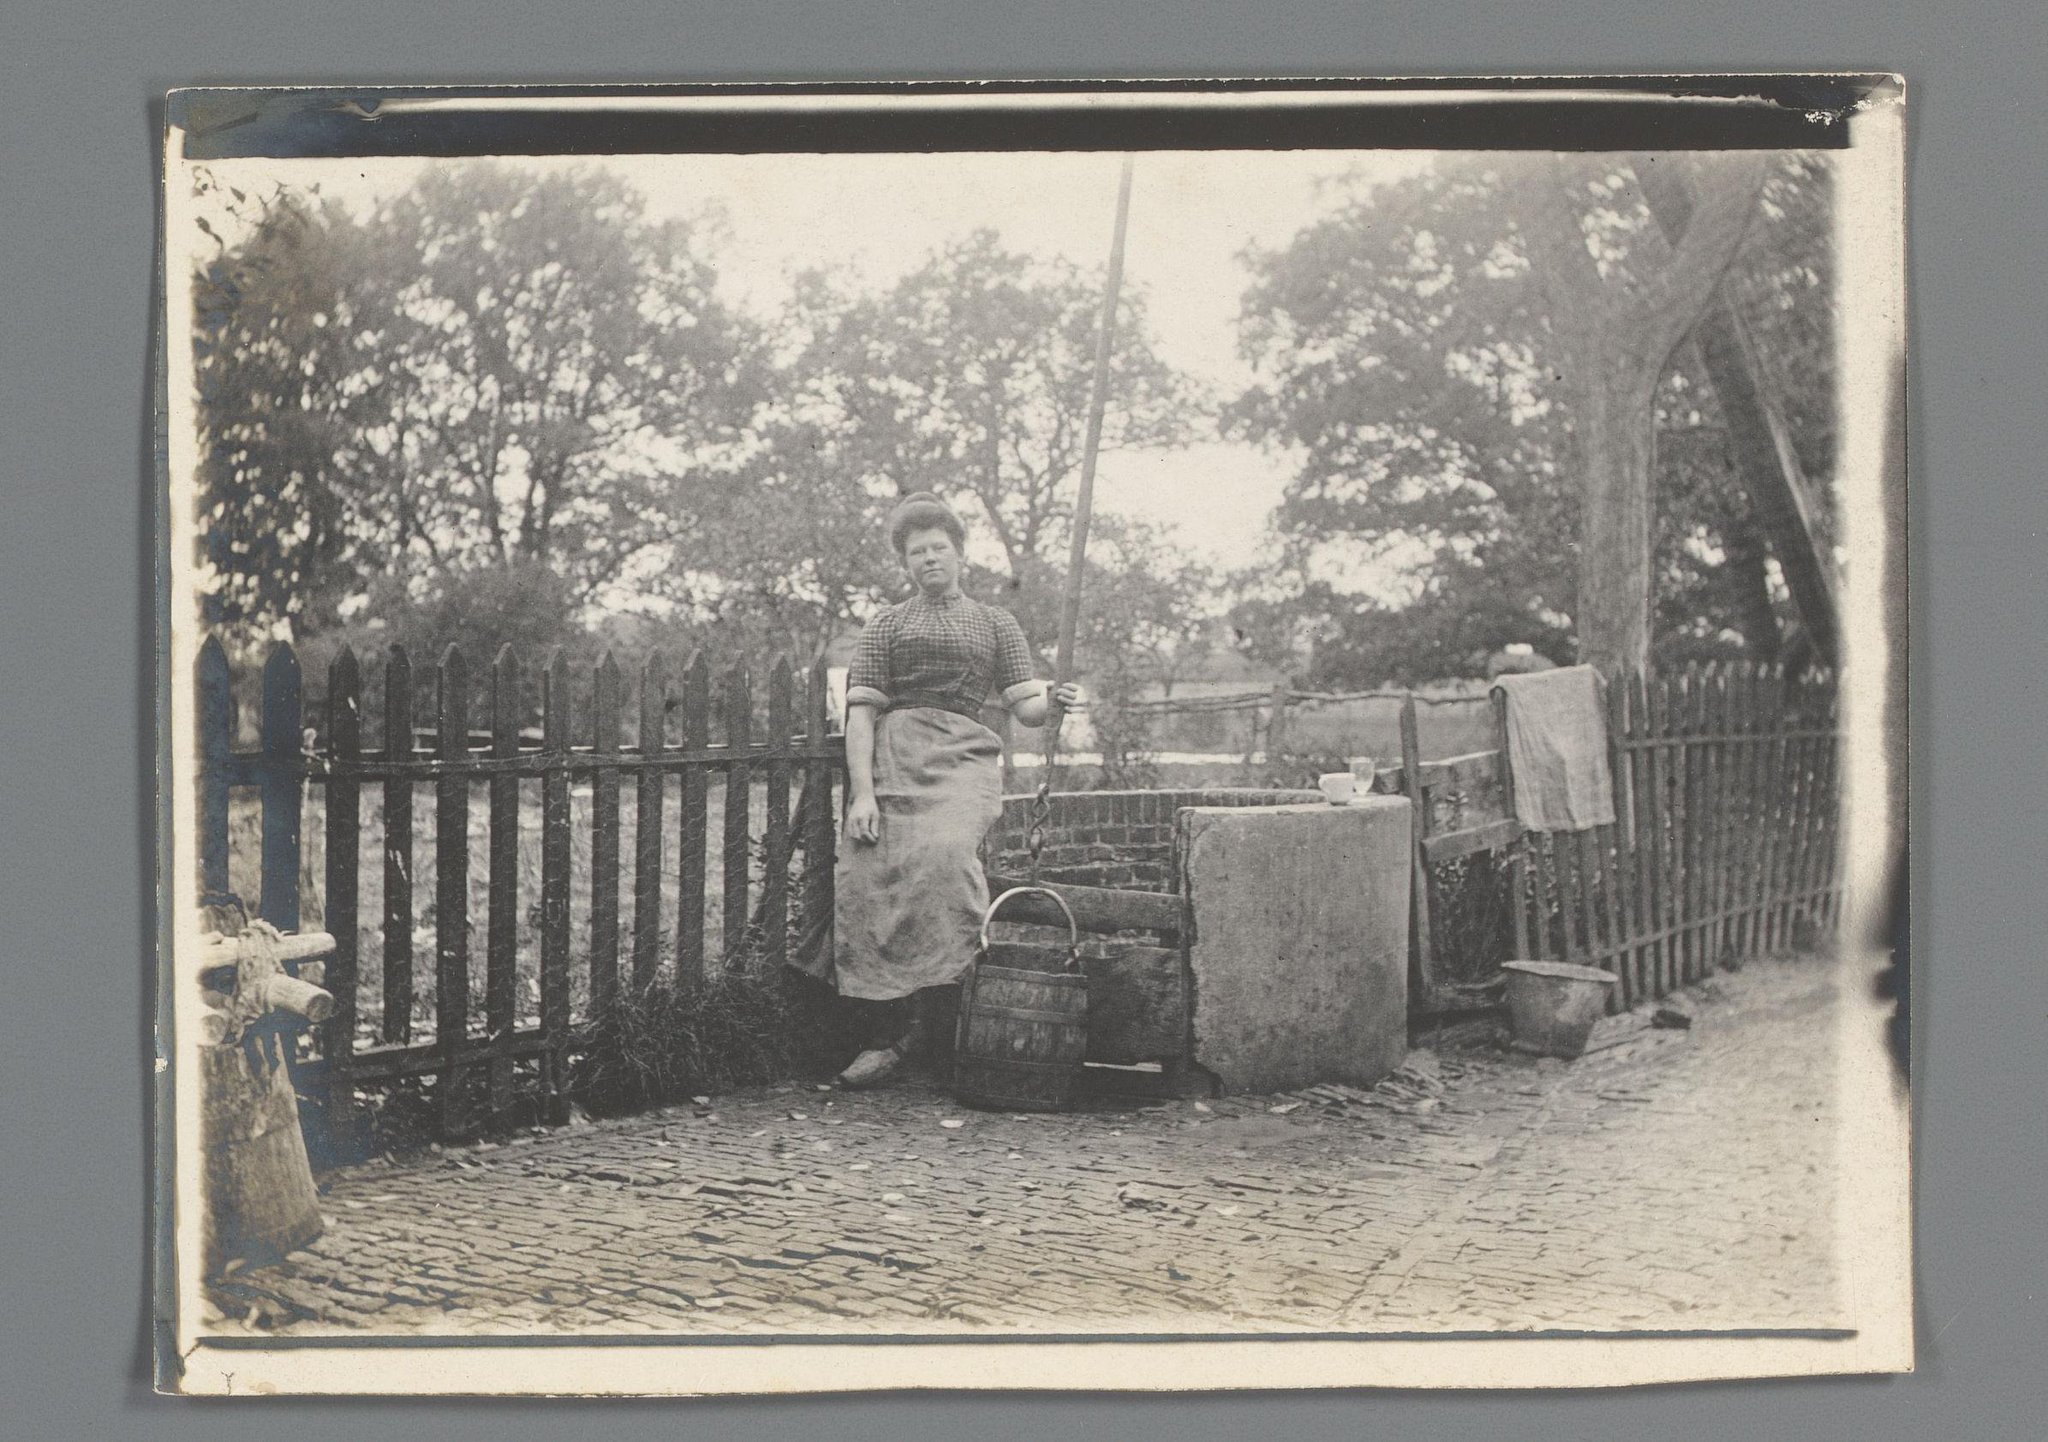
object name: photograph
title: Portret van een onbekende vrouw bij een waterput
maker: willem de jong (fotograaf)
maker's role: arts, fotograaf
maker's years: 1864-1918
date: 1895-1918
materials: paper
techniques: gelatin silver print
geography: netherlands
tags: well, historical persons not known by name - bb - woman